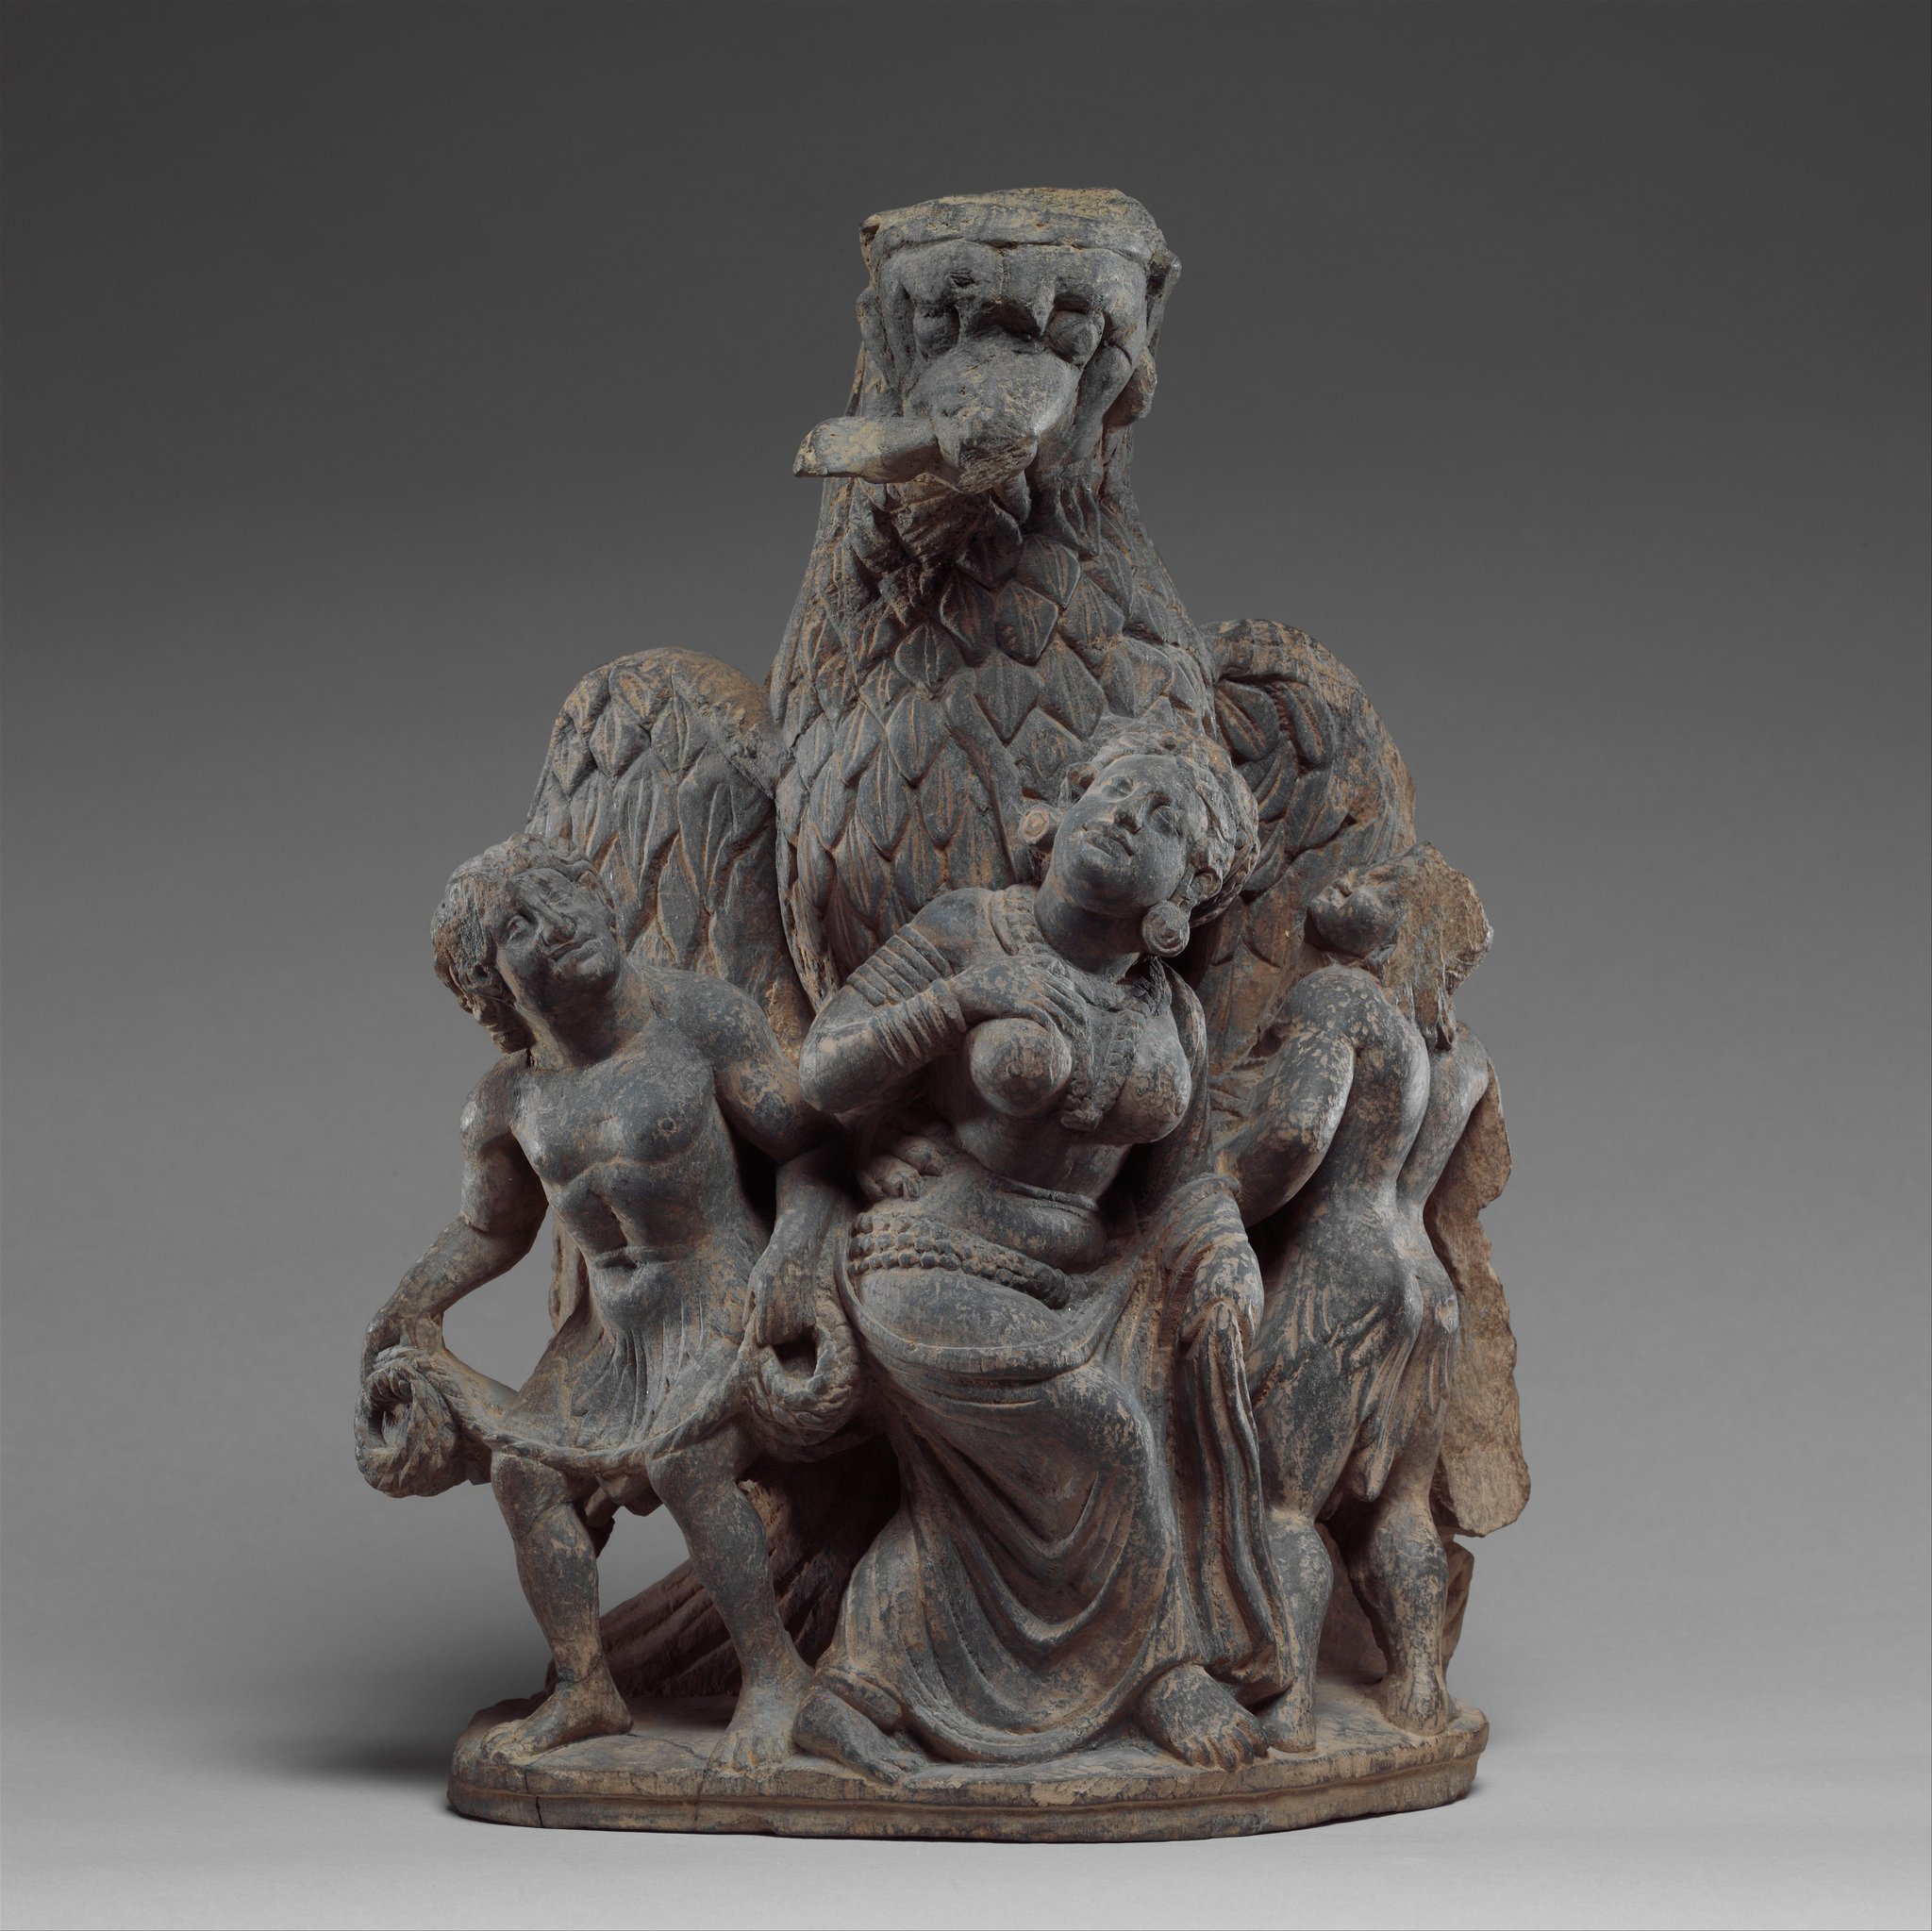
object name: figure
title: Garuda Vanquishing the Naga Clan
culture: gandhara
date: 101-300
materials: stone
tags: gandhara,men,women,mythical creatures